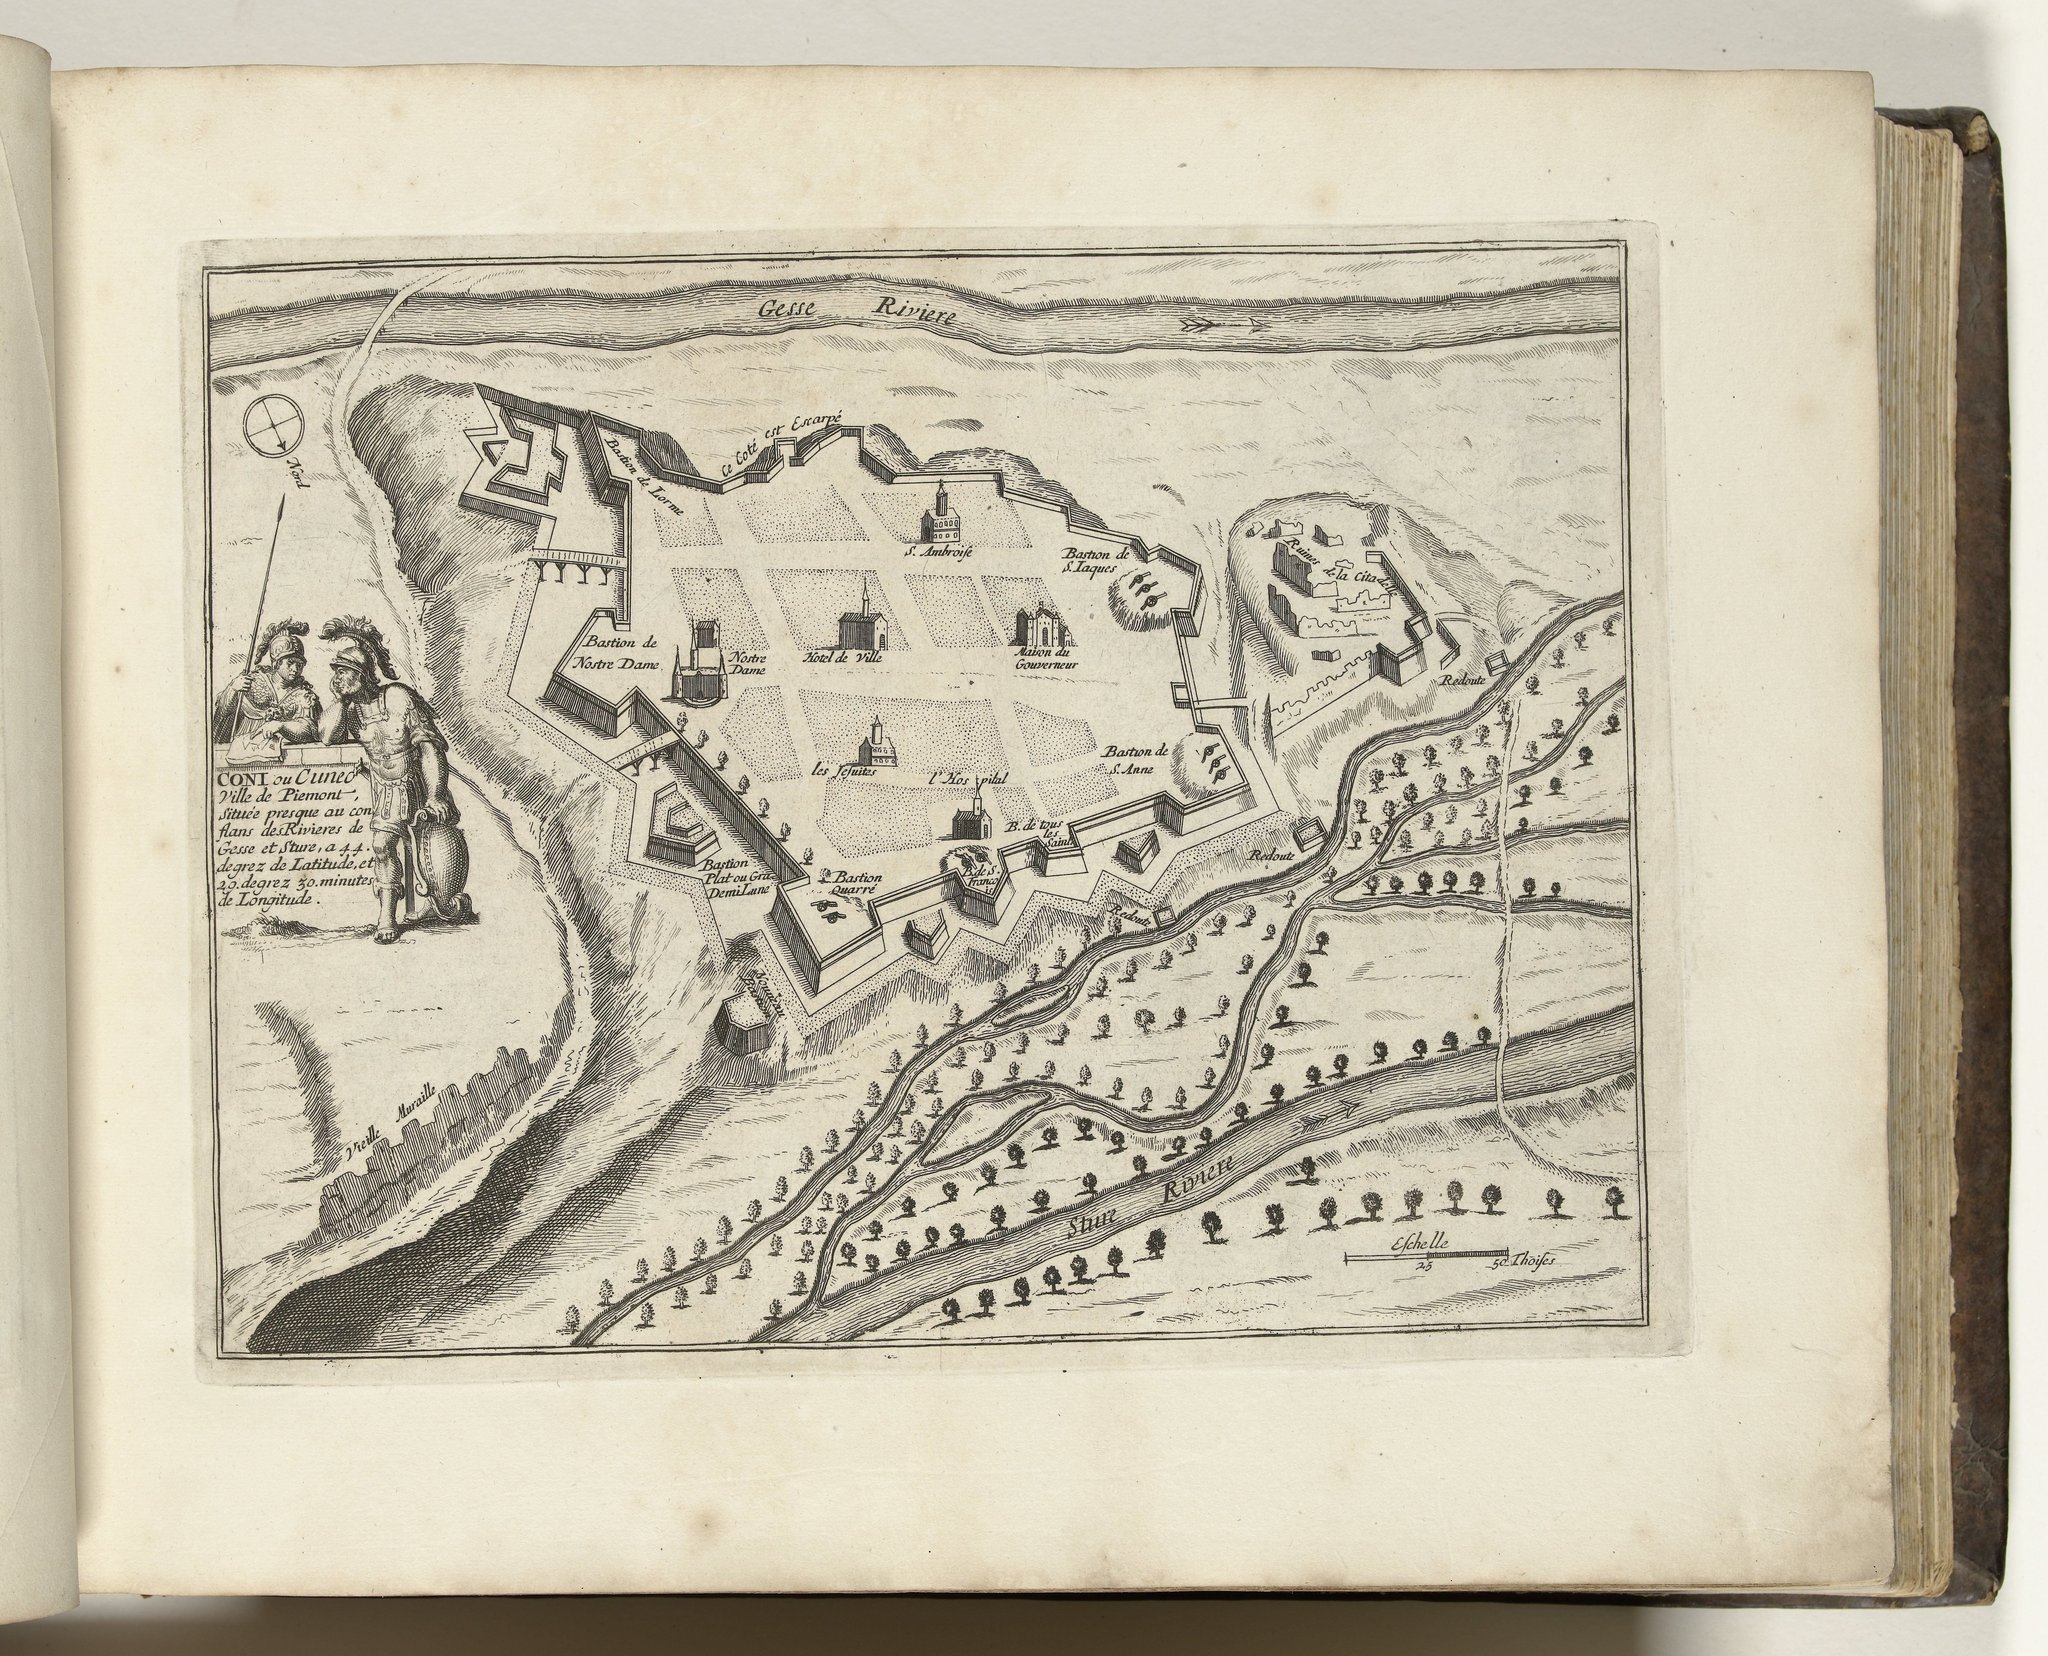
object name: print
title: Plattegrond van Cuneo, 1693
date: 1693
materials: paper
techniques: etching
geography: france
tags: fortress, maps of cities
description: Plattegrond van de versterkingen rond de Italiaanse stad Cuneo (Coni). Onderdeel van het tweede deel (1693) van het prentwerk waarin gebundeld zijn de acht delen van Les forces de l'Europe uitgegeven tussen 1693-1697. Het prentwerk bestaat uit 175 platen met plannen (afkomstig van Sébastien Le Prestre, Seigneur de Vauban) van vermaarde sterke steden en vestingen in de Negenjarige Oorlog. Titel en opschriften in het Frans.